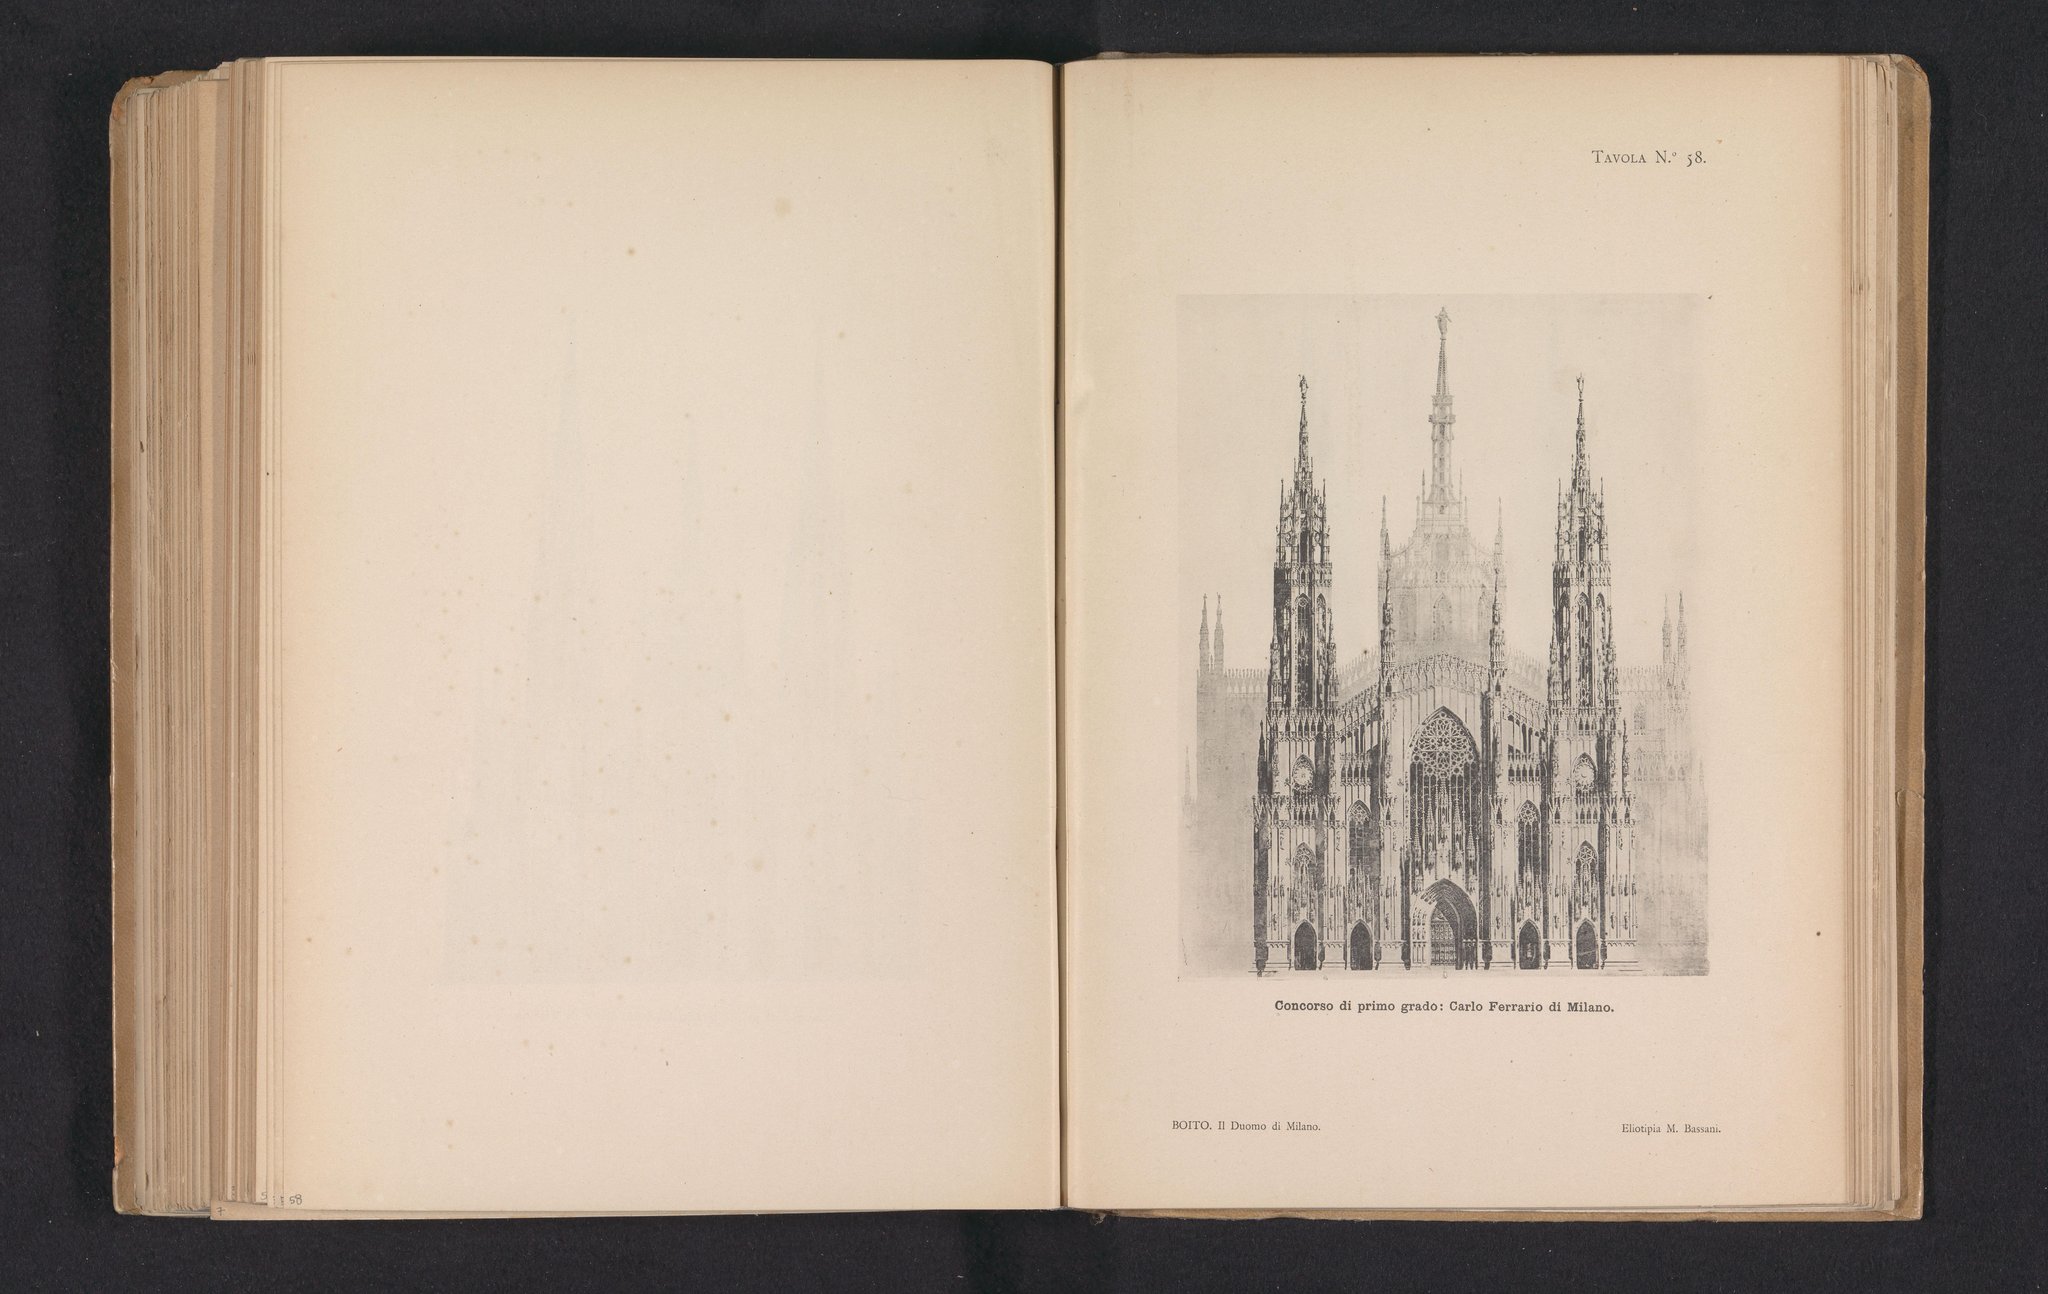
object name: page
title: Concorso di primo grado : Carlo Ferrario di Milano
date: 1886-1889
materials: paper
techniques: photograph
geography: milan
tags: drawing, sketch, parts of church exterior and annexes: façade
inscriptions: number: ‘Tavola No. 58.’